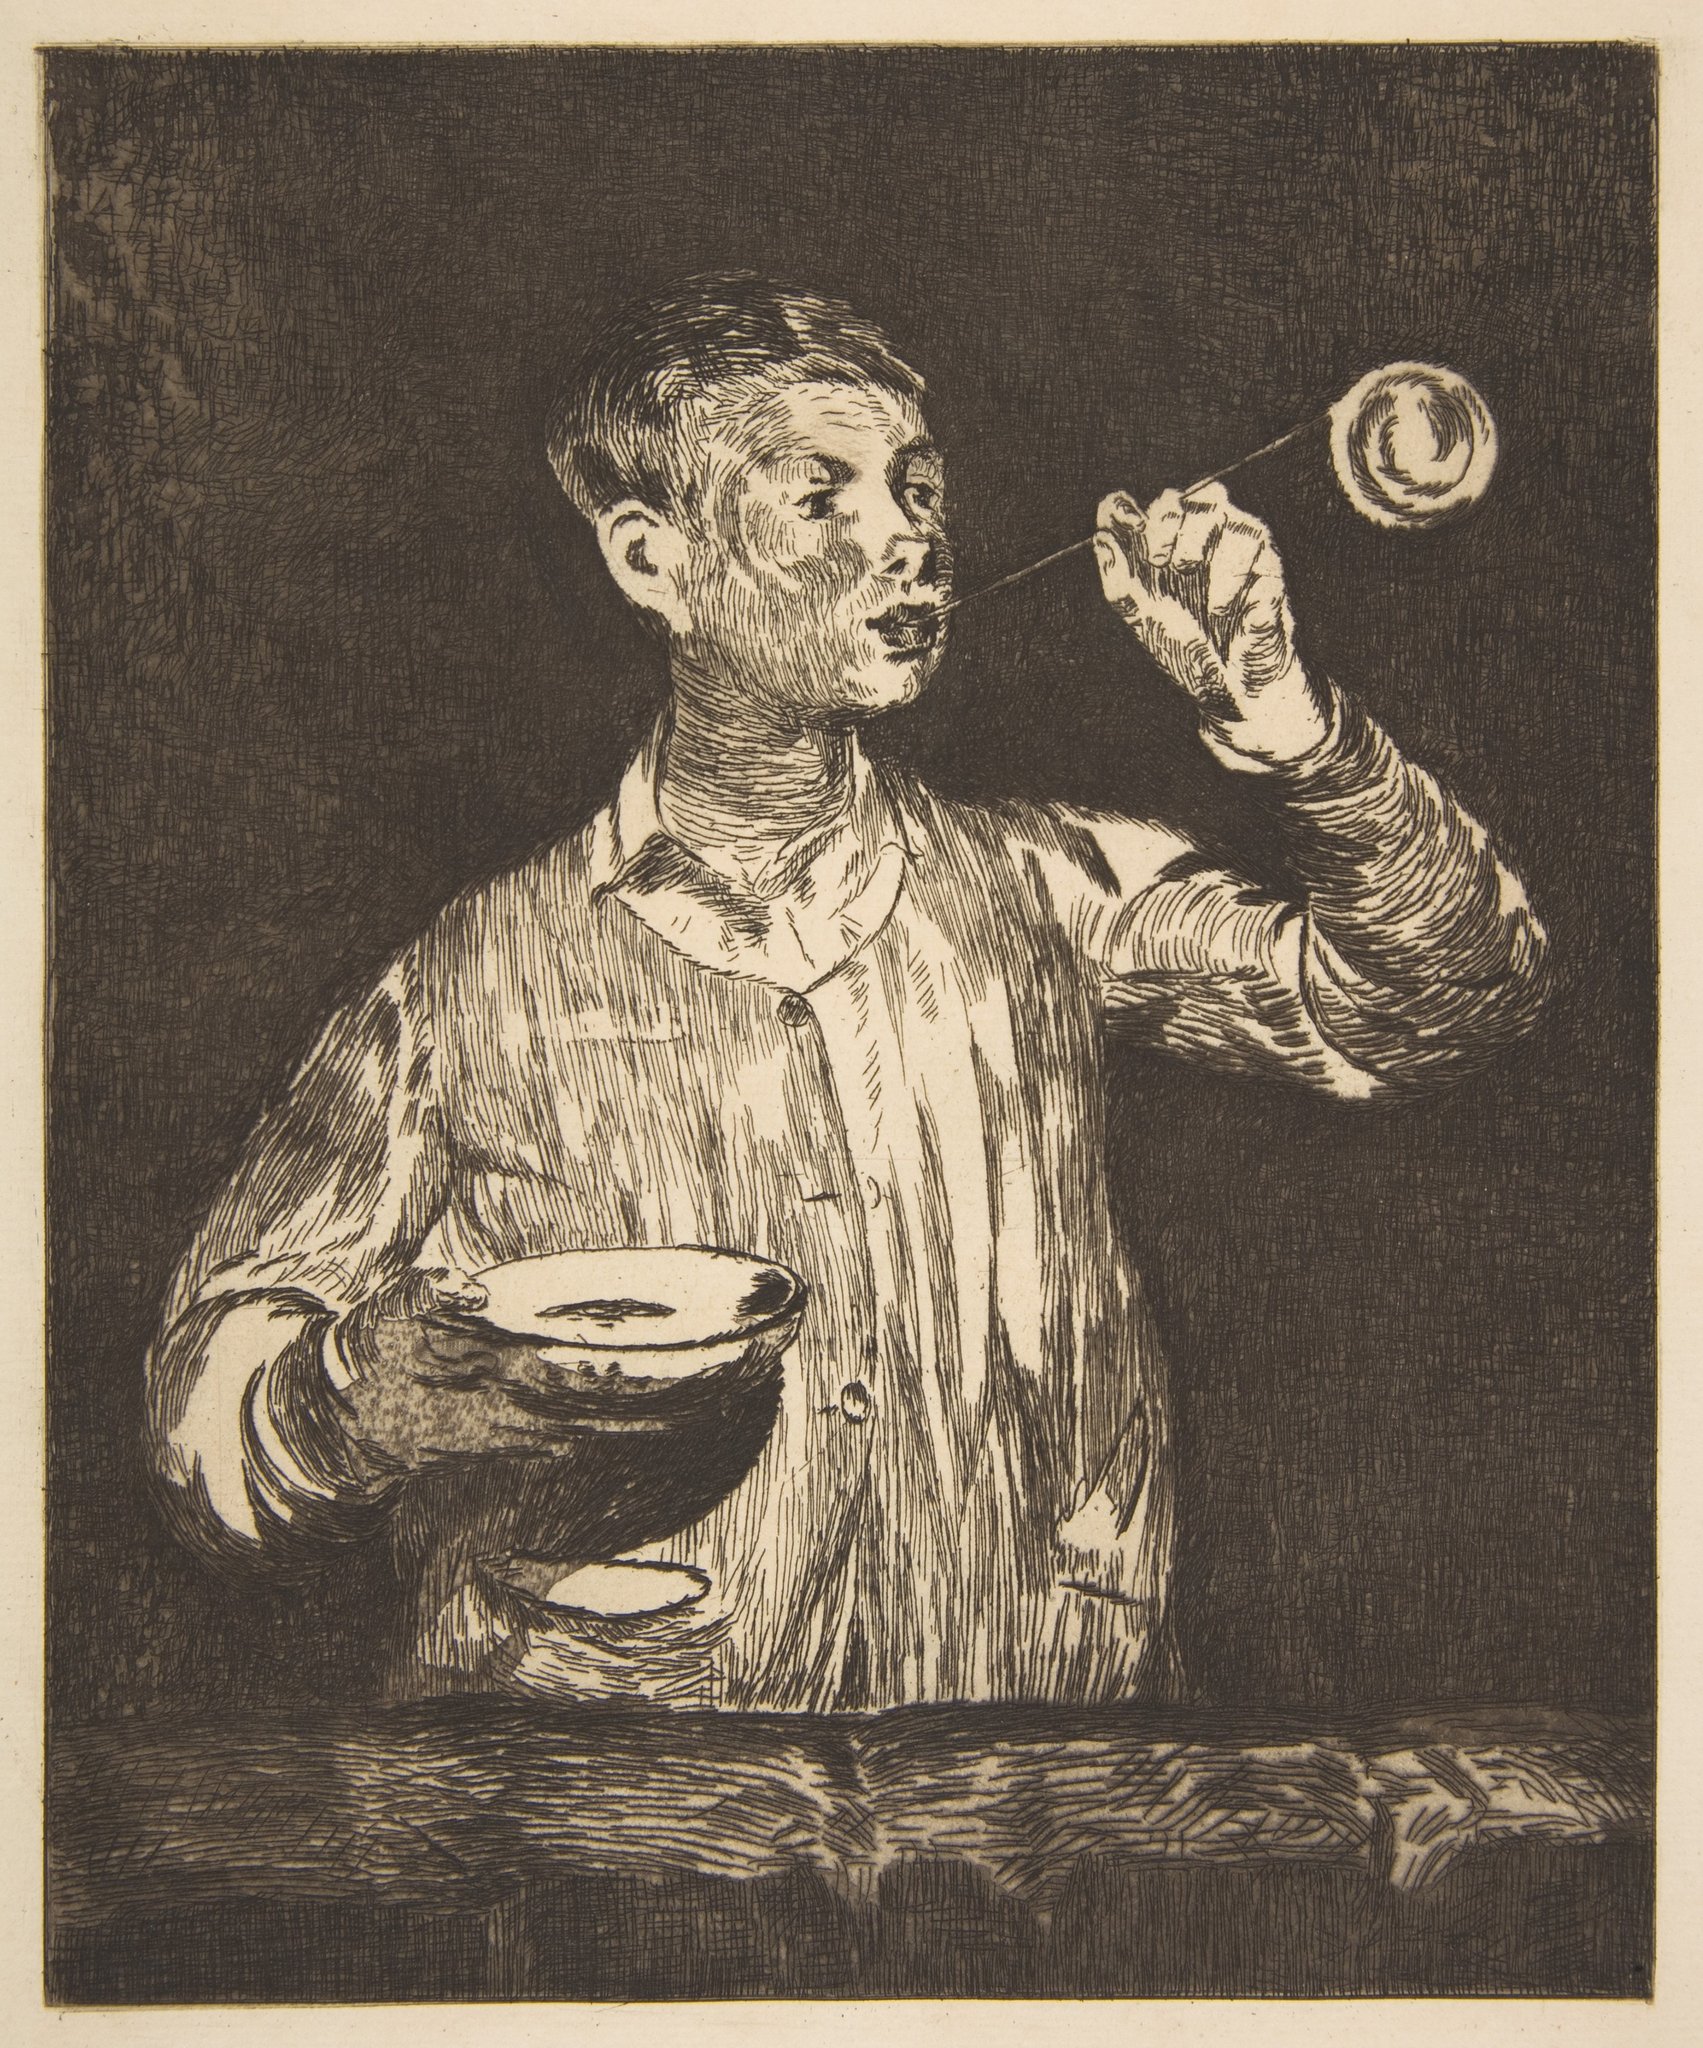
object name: print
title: Boy with Soap Bubbles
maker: édouard manet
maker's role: artist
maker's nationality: french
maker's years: 1832-1883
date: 1867-1869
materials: paper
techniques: aquatint, etching, roulette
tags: boys,bubbles